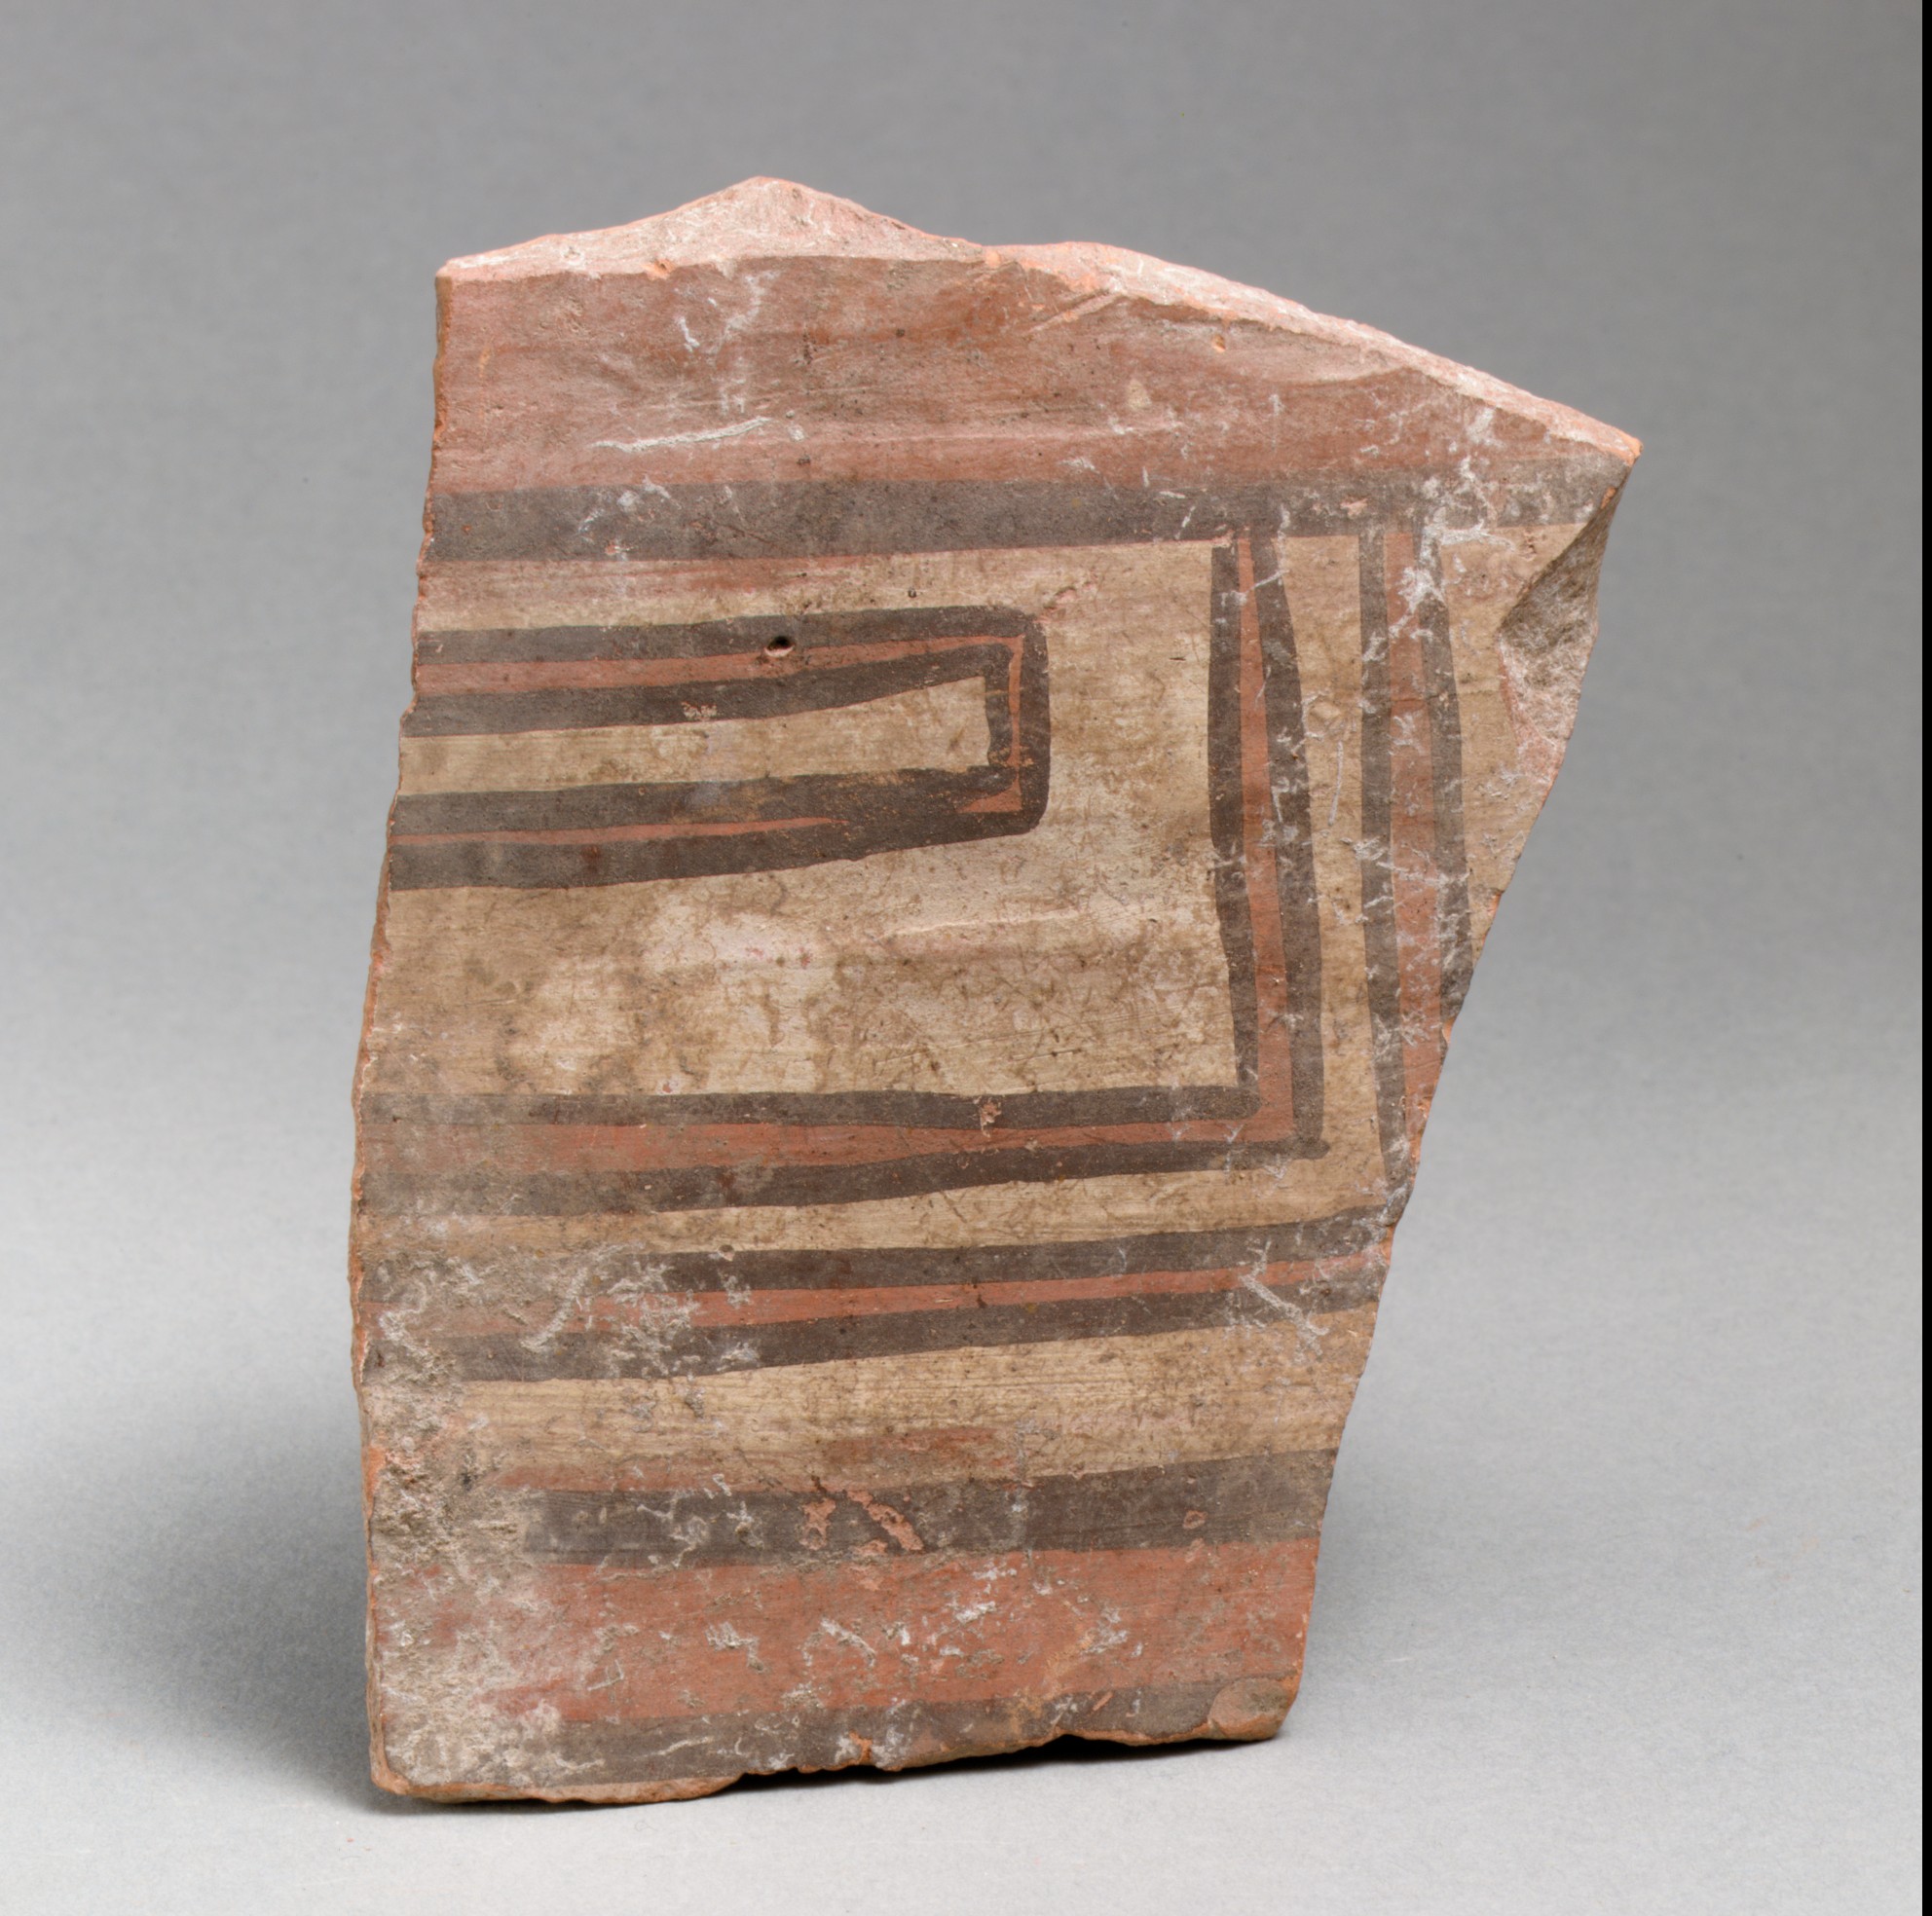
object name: vase fragment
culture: greek or lydian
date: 800-480 BCE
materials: terracotta